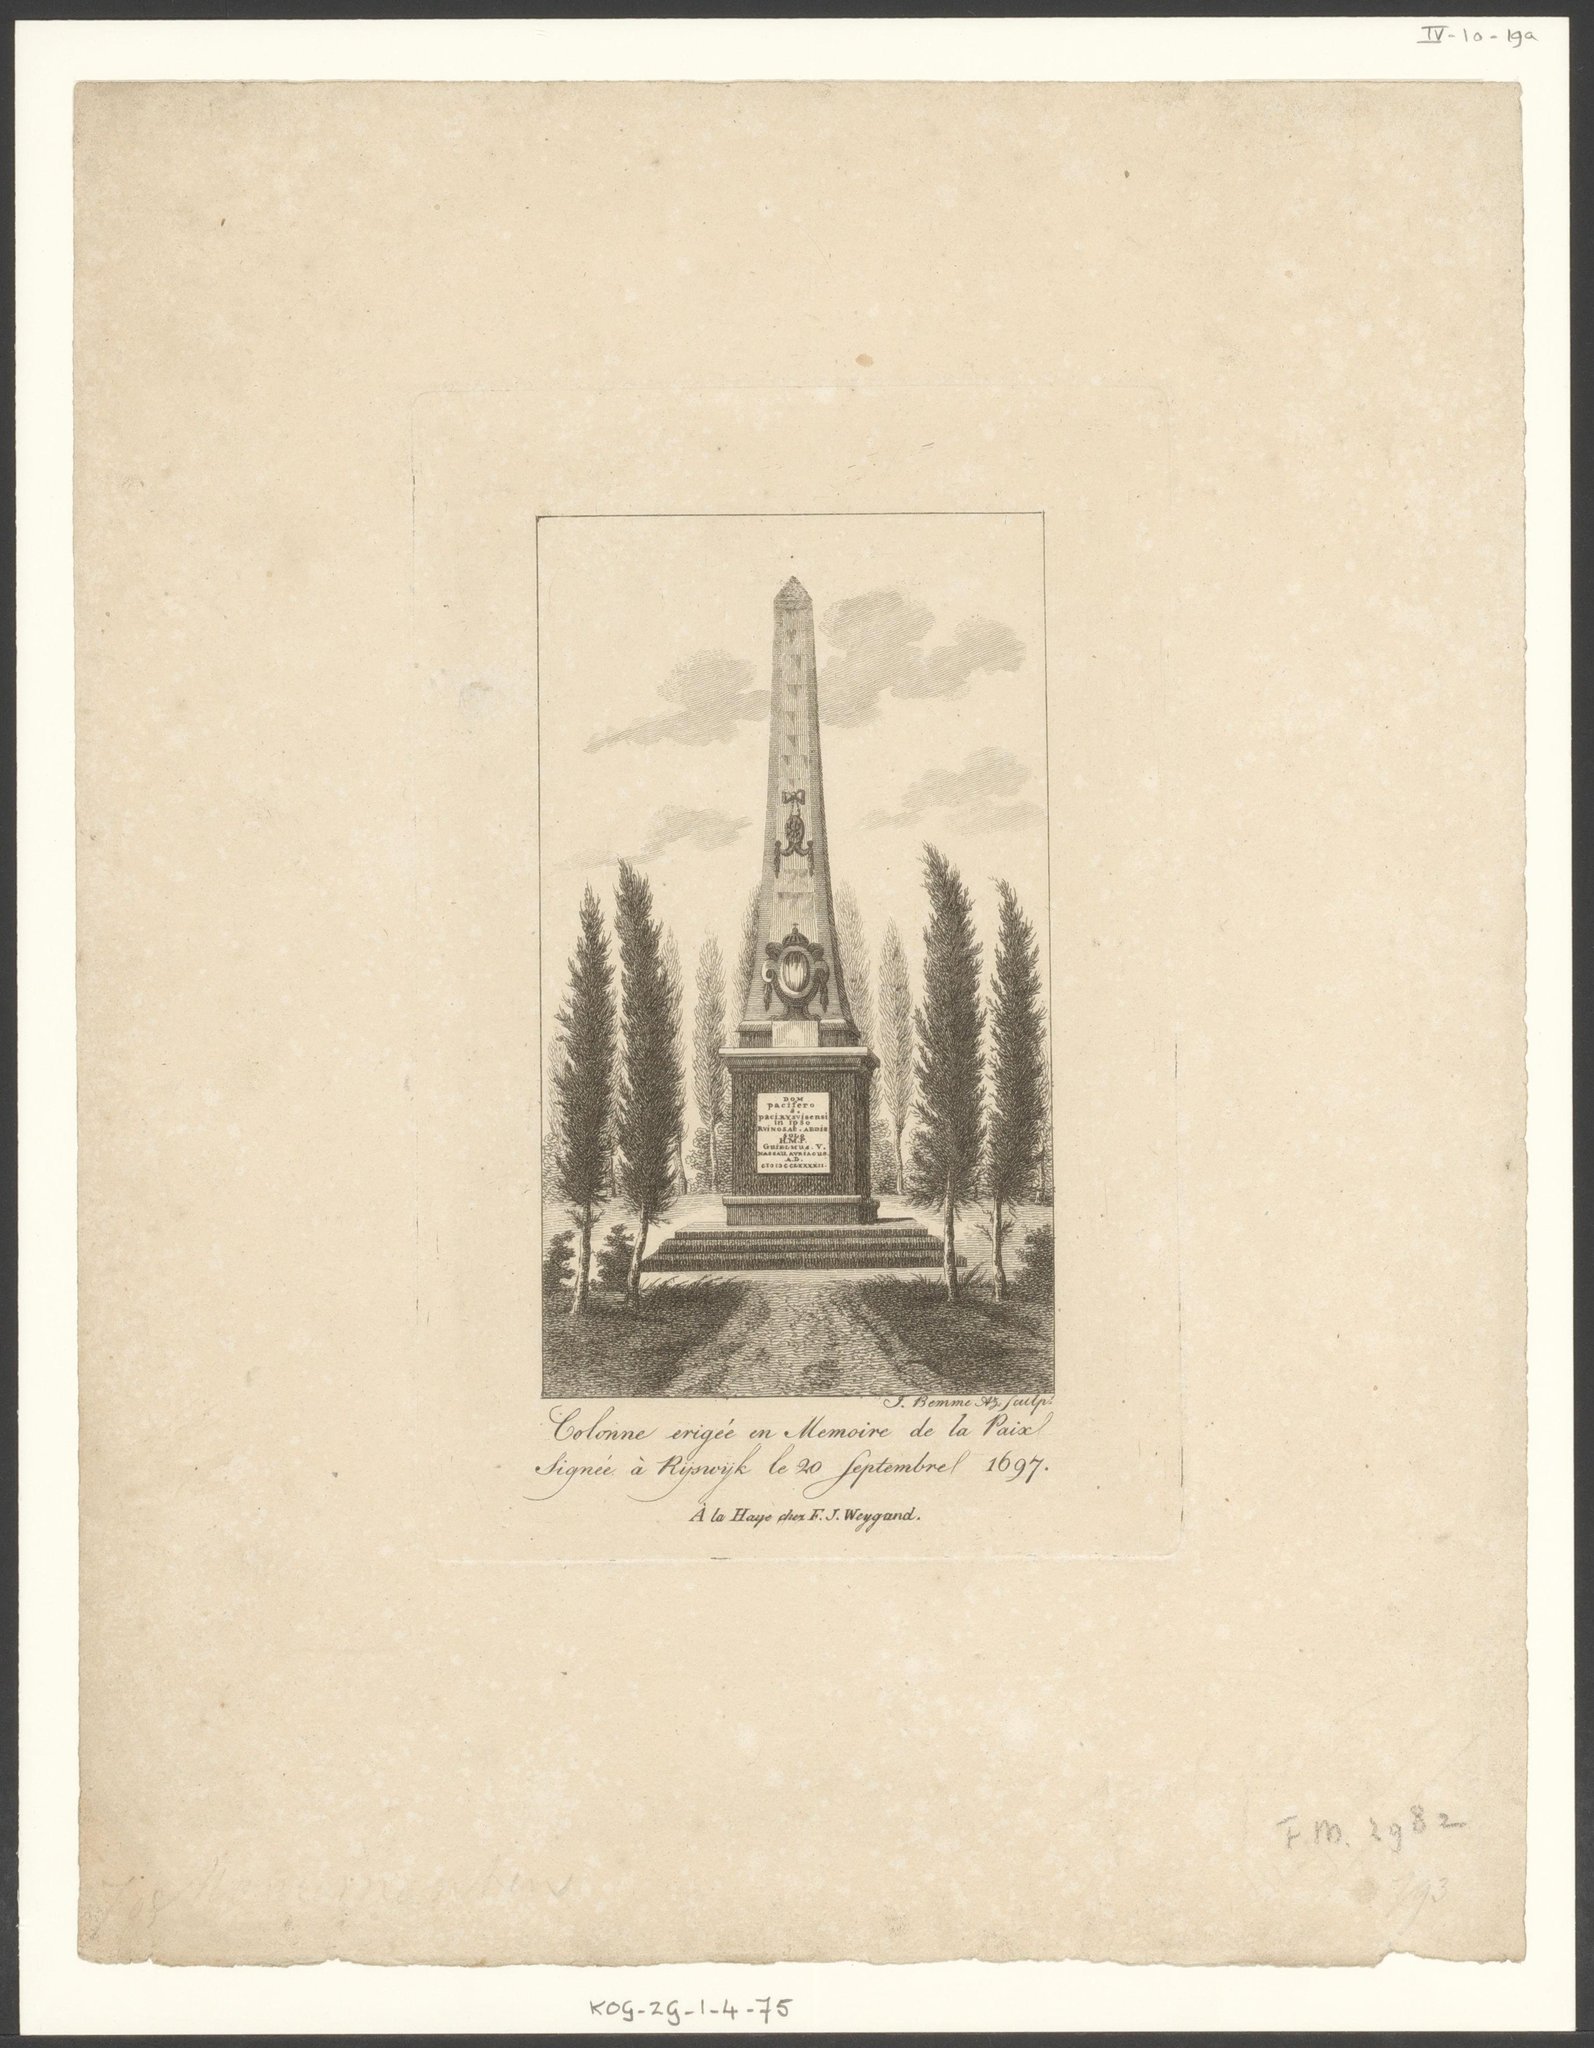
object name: print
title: Colonne erigée en Memoire de la Paix Signée à Rijswijk le 20 Septembre 1697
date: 1792-1799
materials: paper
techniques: etching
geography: netherlands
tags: monument, statue